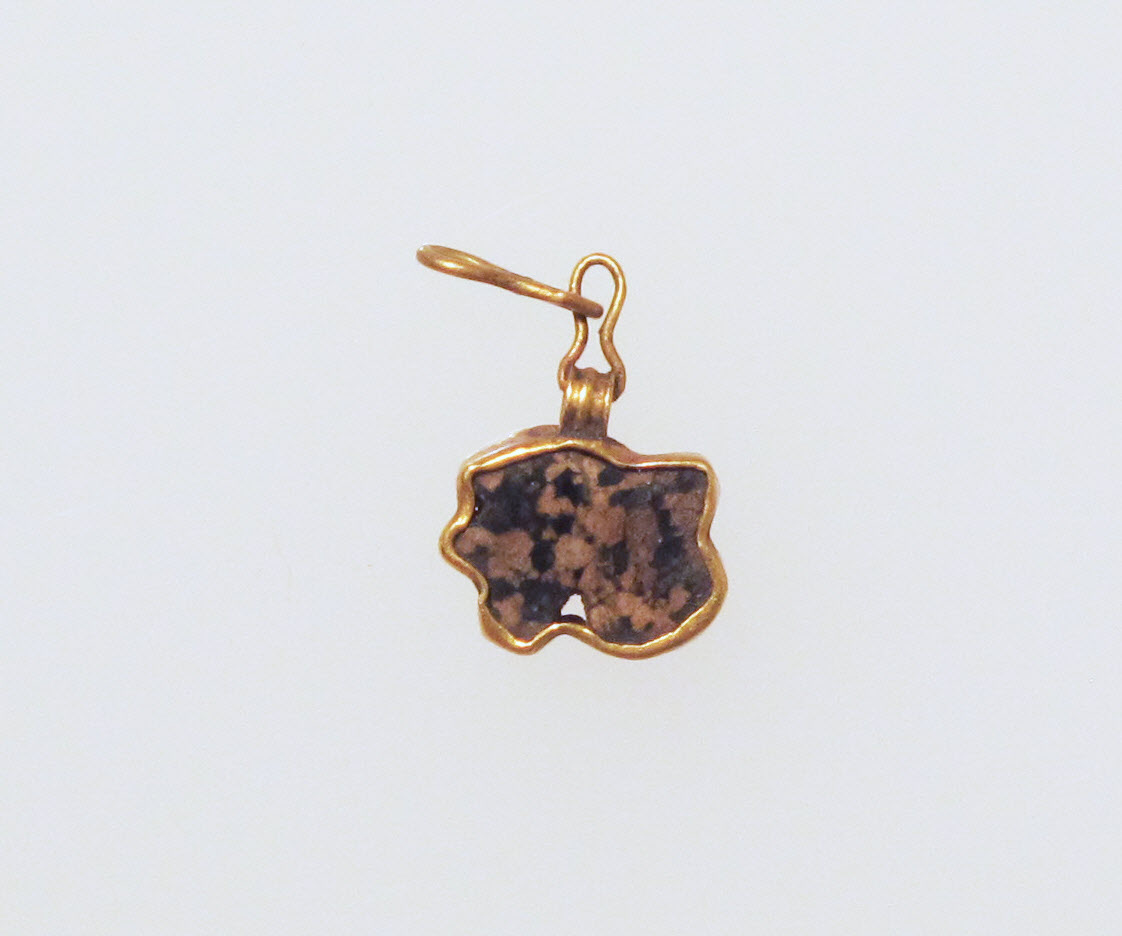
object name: pendant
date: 7000 BCE-330 CE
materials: gold